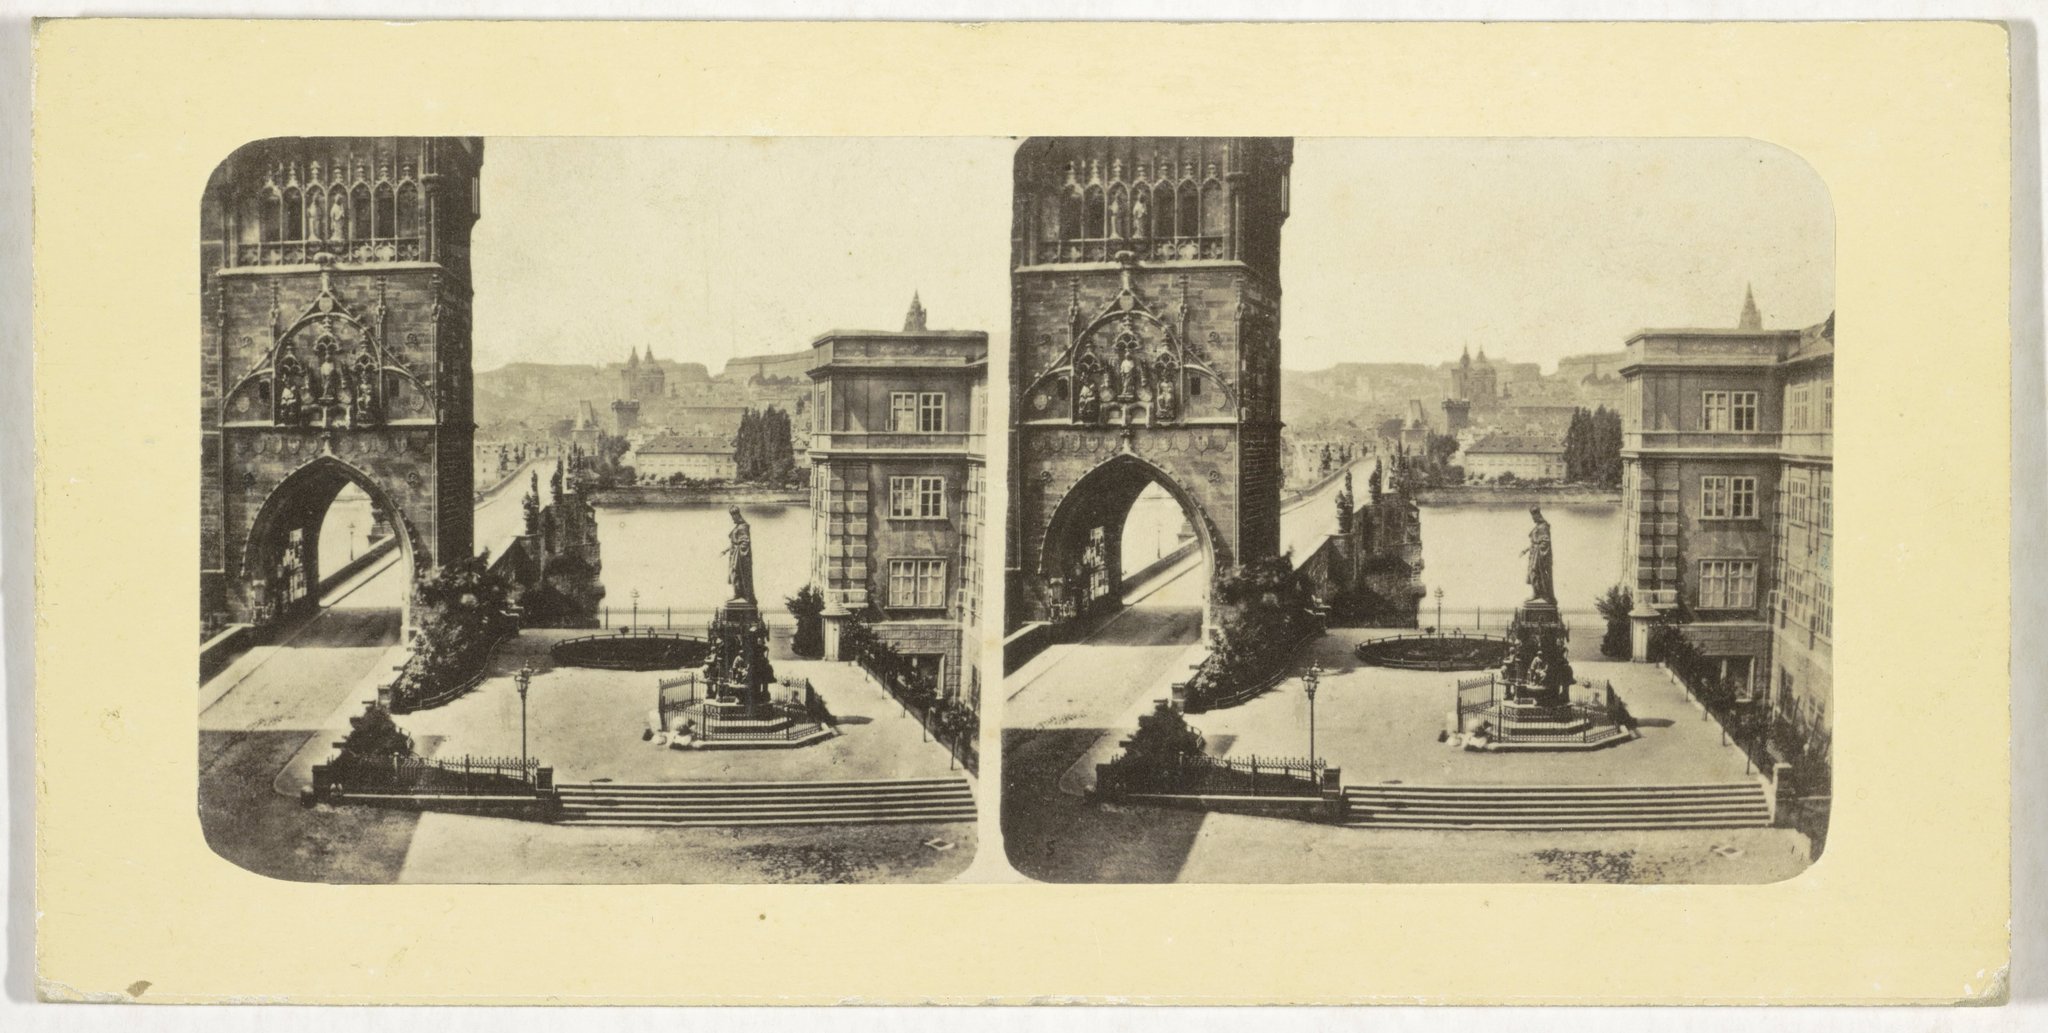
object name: stereograph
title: Karelsbrug en het monument voor keizer Karel IV, Praag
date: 1857-1863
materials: cardboard, paper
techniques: albumen print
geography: prague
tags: towers ~ fortified city, monument, statue, bridge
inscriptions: number: ‘No 12’, retailer's mark: ‘Zur Stadt Paris/ No 596/ 1/ Prag’